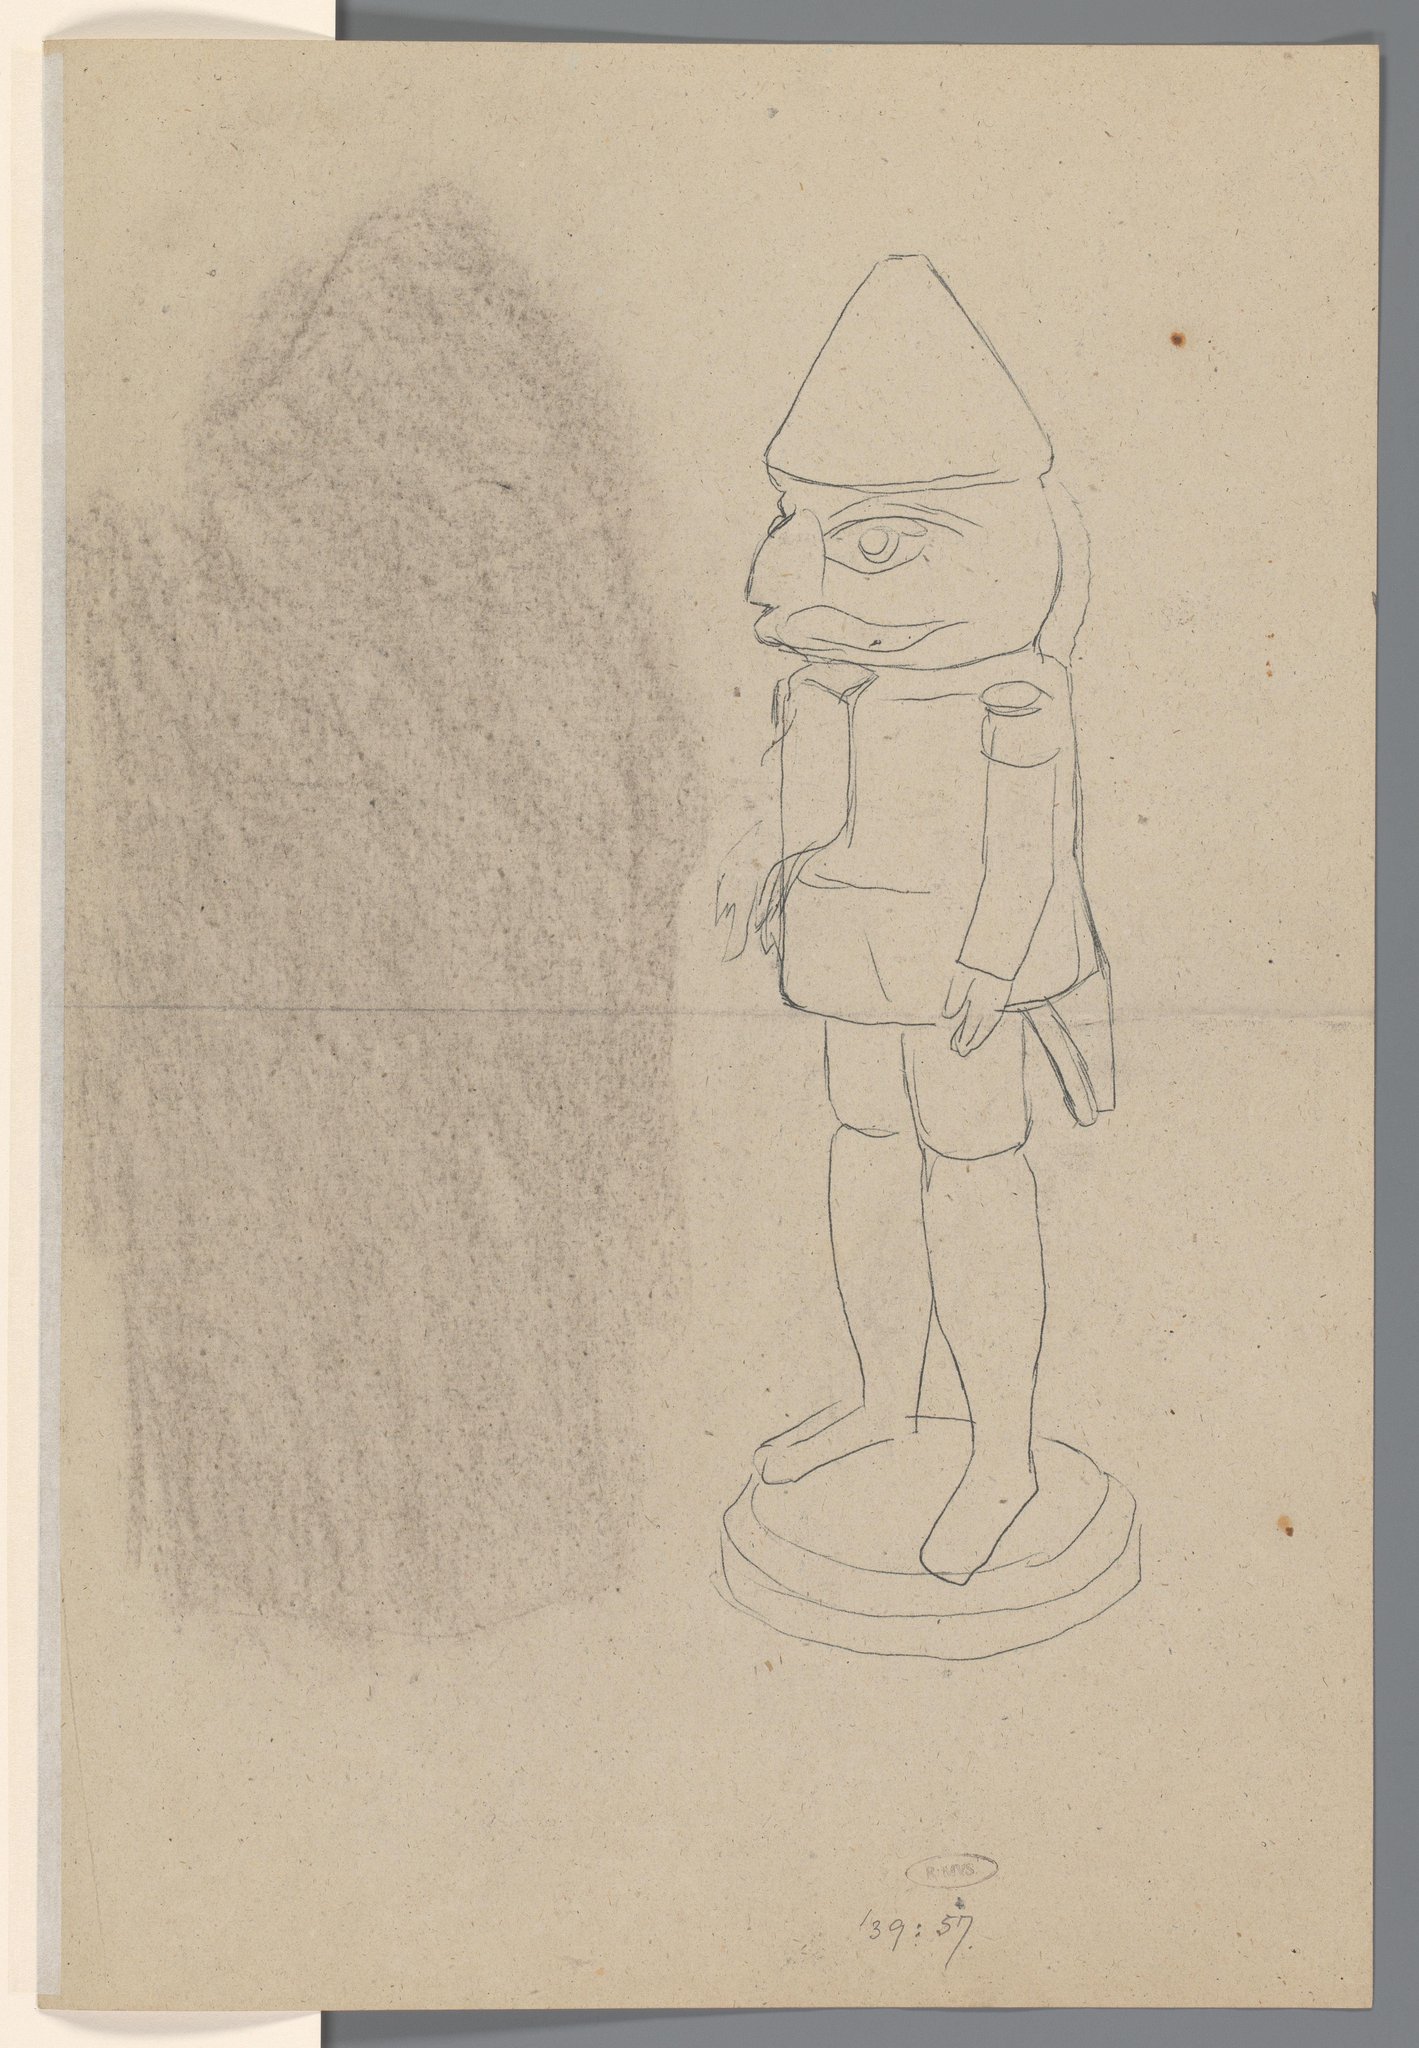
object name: drawing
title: Zijaanzicht van de Notenkraker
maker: willem wenckebach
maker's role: designer, draughtsman, painter, print maker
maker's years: 1860-1937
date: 1898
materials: ink, paper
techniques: pen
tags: (playing with) dolls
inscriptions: collector's mark: Lugt 2228a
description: Ontwerp voor: Hoffman, Ernst Theodor Amadeus. Notenkraker en muizenkoning. Amsterdam: Scheltema & Holkema, 1898.